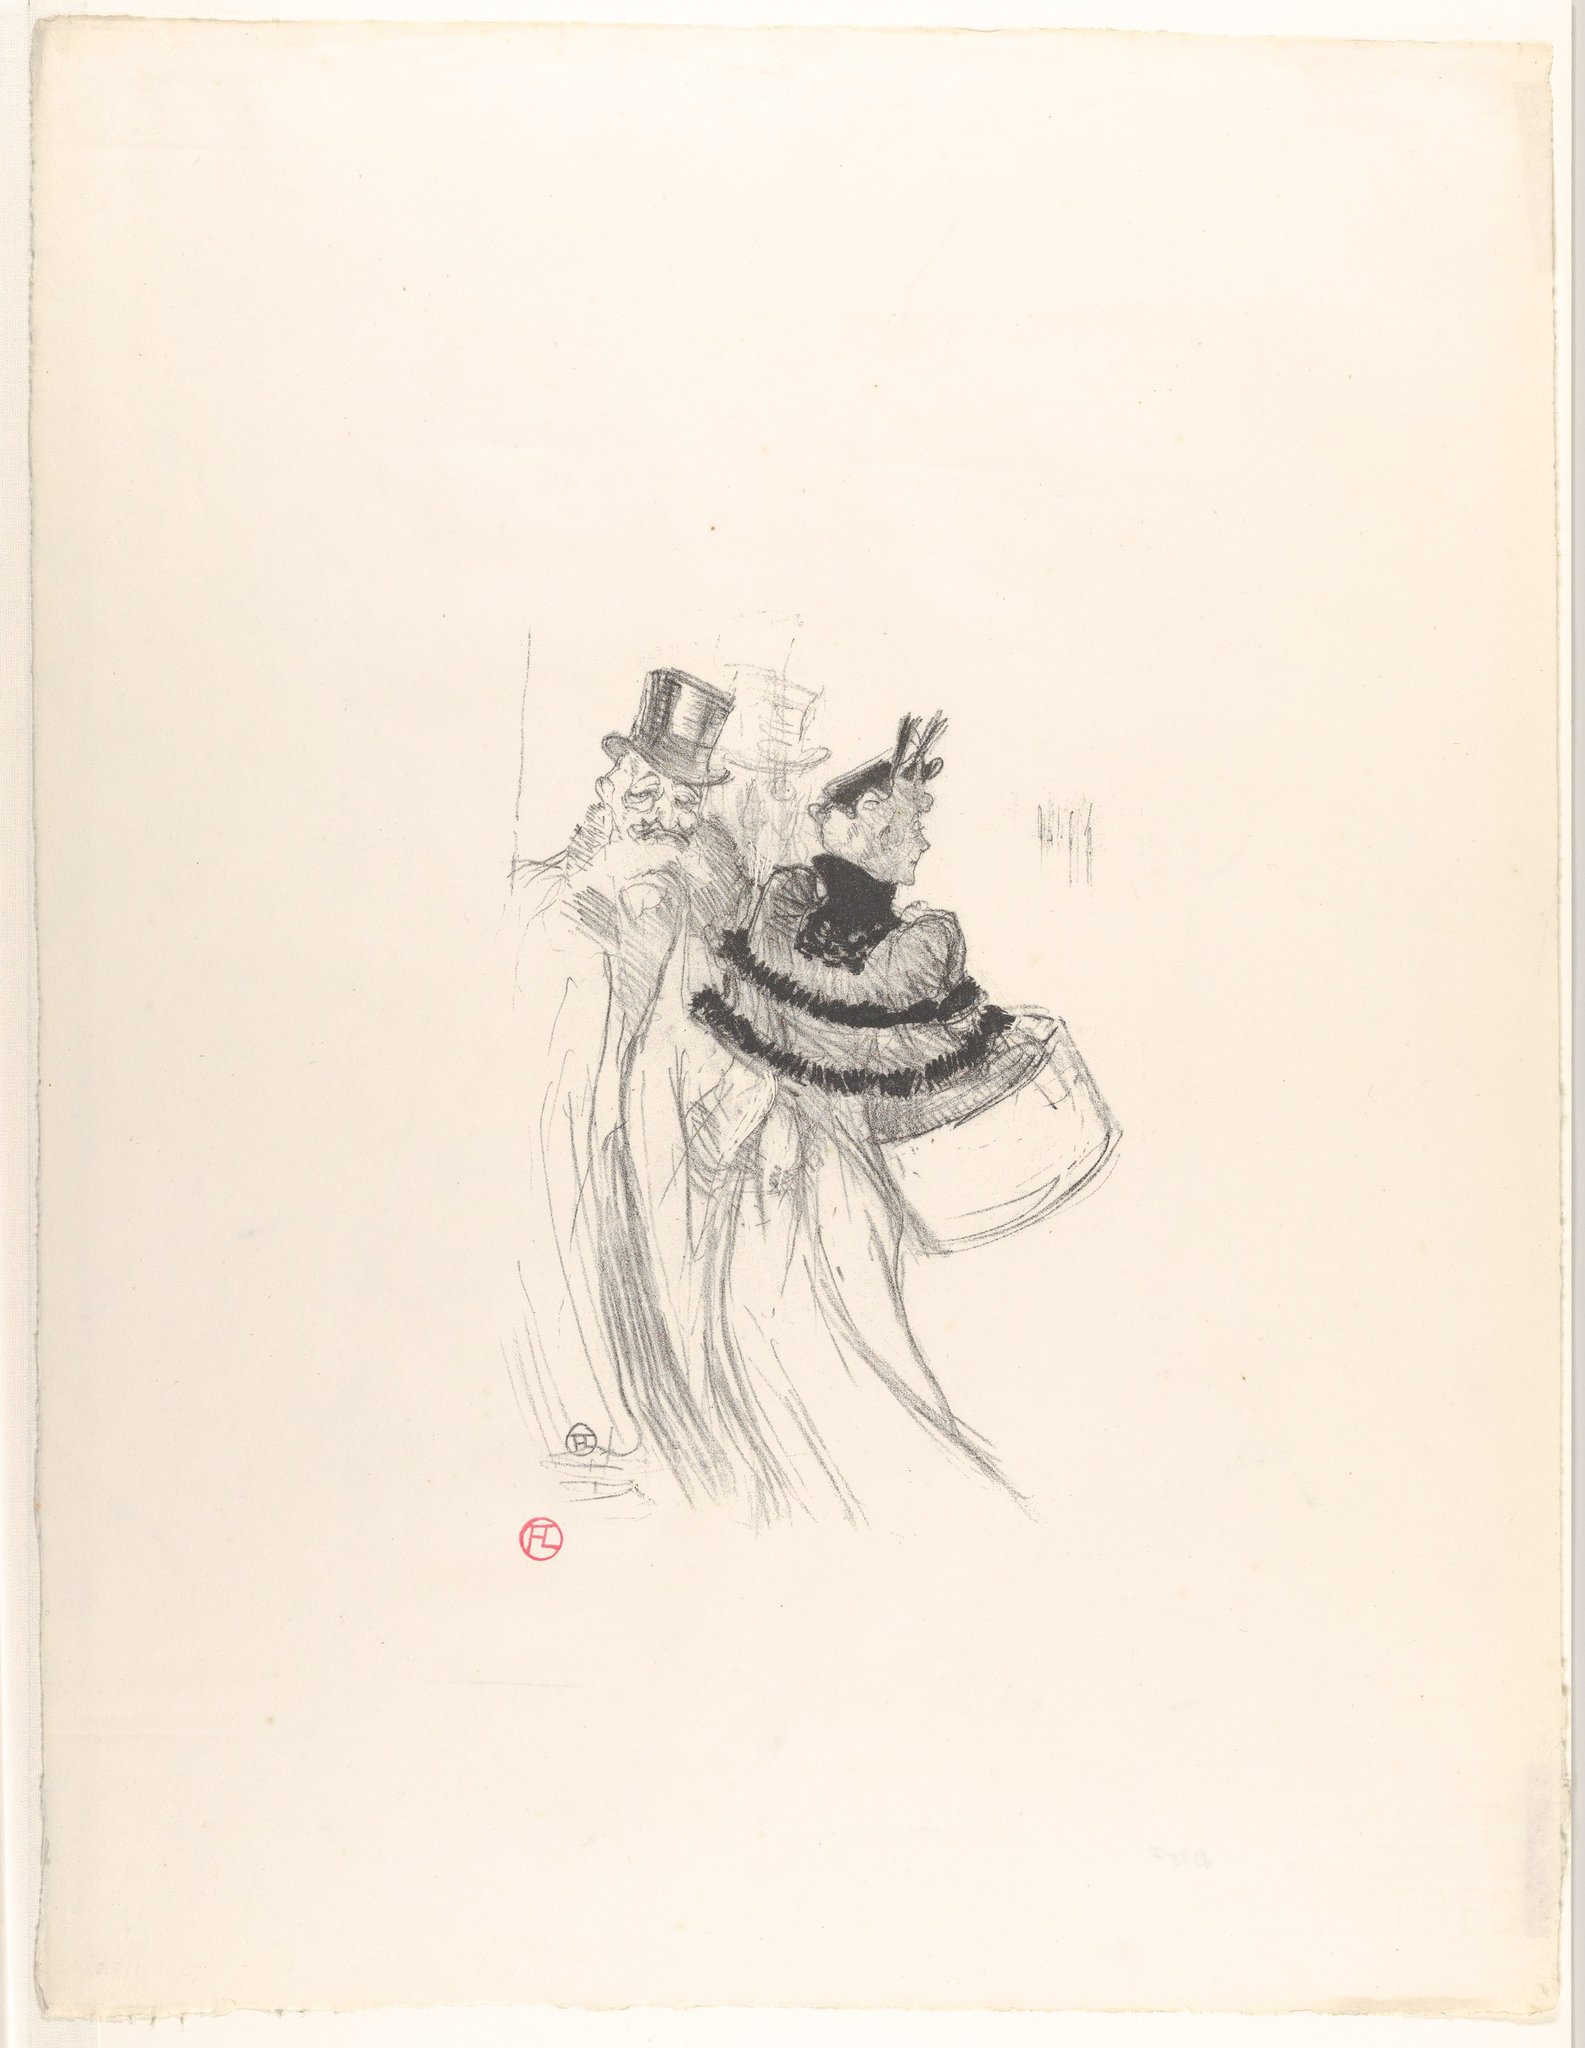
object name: print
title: "Les Vieux Messieurs" (The Old Gentlemen)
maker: henri de toulouse-lautrec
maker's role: artist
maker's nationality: french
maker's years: 1864-1901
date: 1894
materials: paper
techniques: lithograph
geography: france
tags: men,women